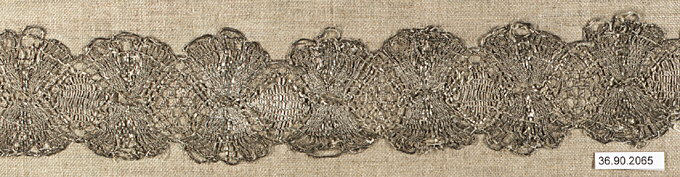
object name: piece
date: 1801-1900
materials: metal thread, silk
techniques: lace